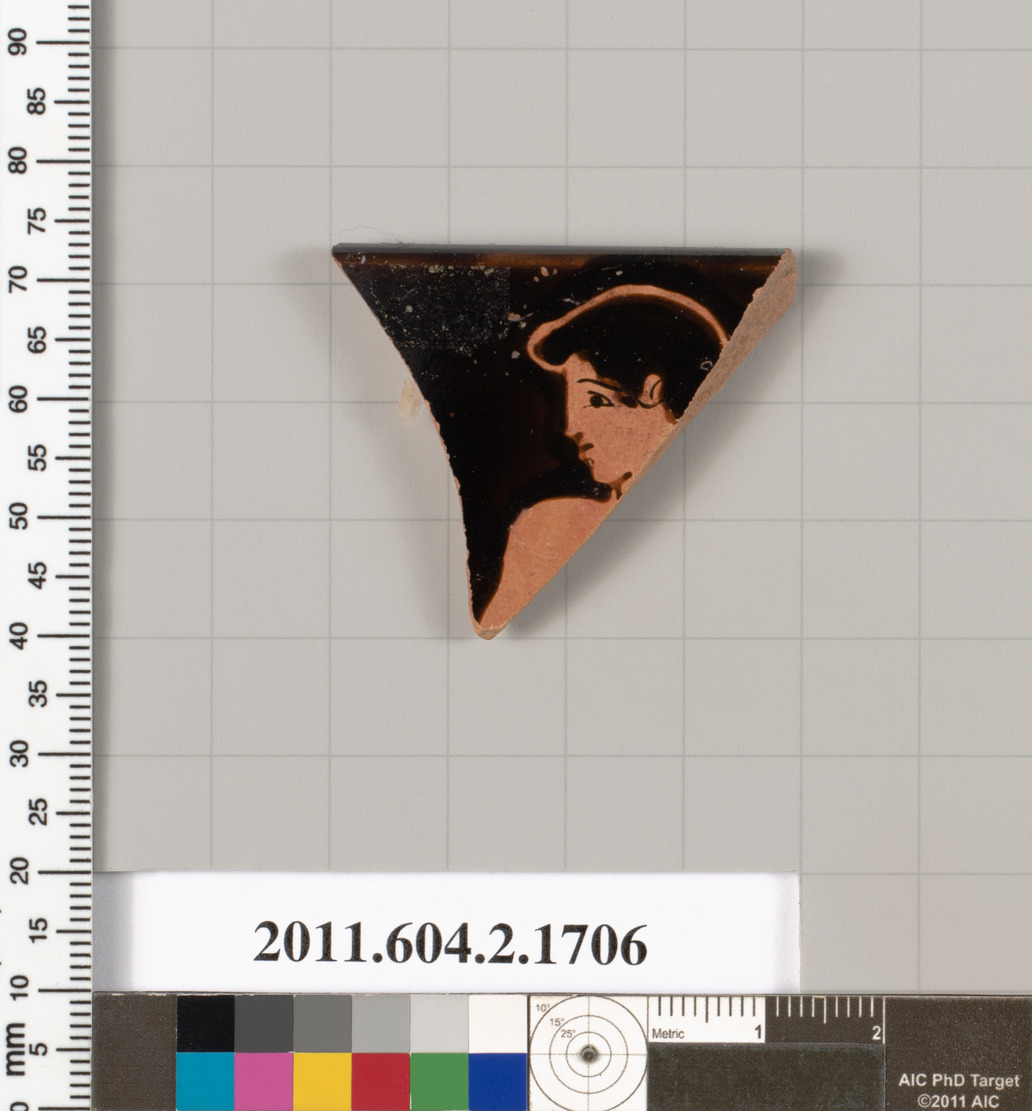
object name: skyphos fragment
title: Terracotta rim fragment of a skyphos (deep drinking cup)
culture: greek, attic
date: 475-451 BCE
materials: terracotta